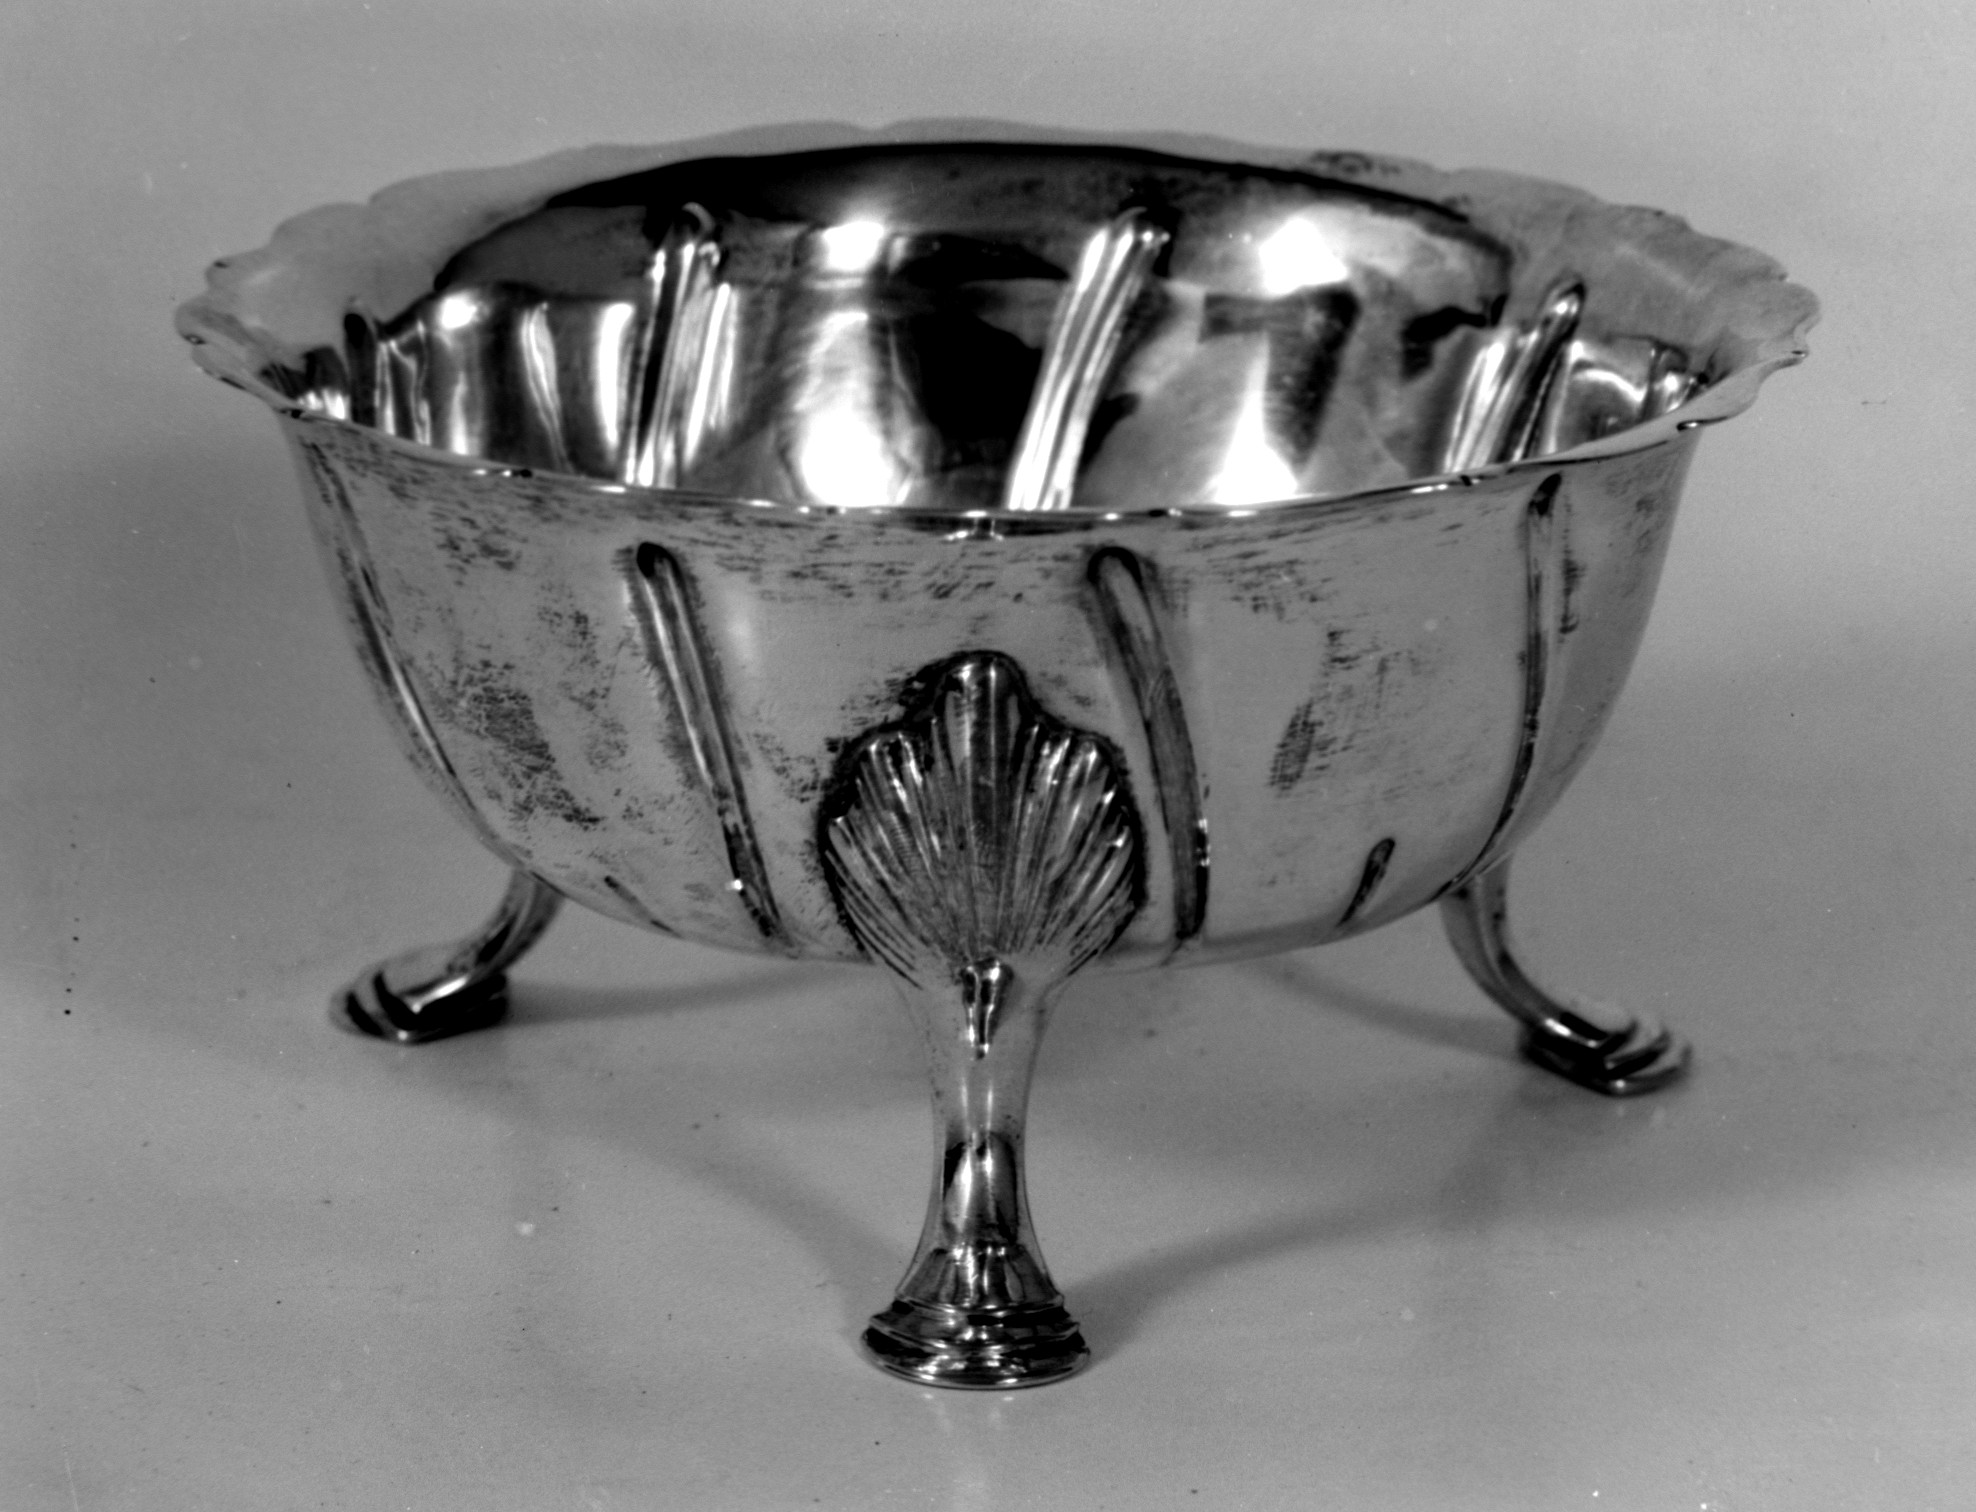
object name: bowl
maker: charles townsend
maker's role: maker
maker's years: 1770-1785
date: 1770-1785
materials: silver